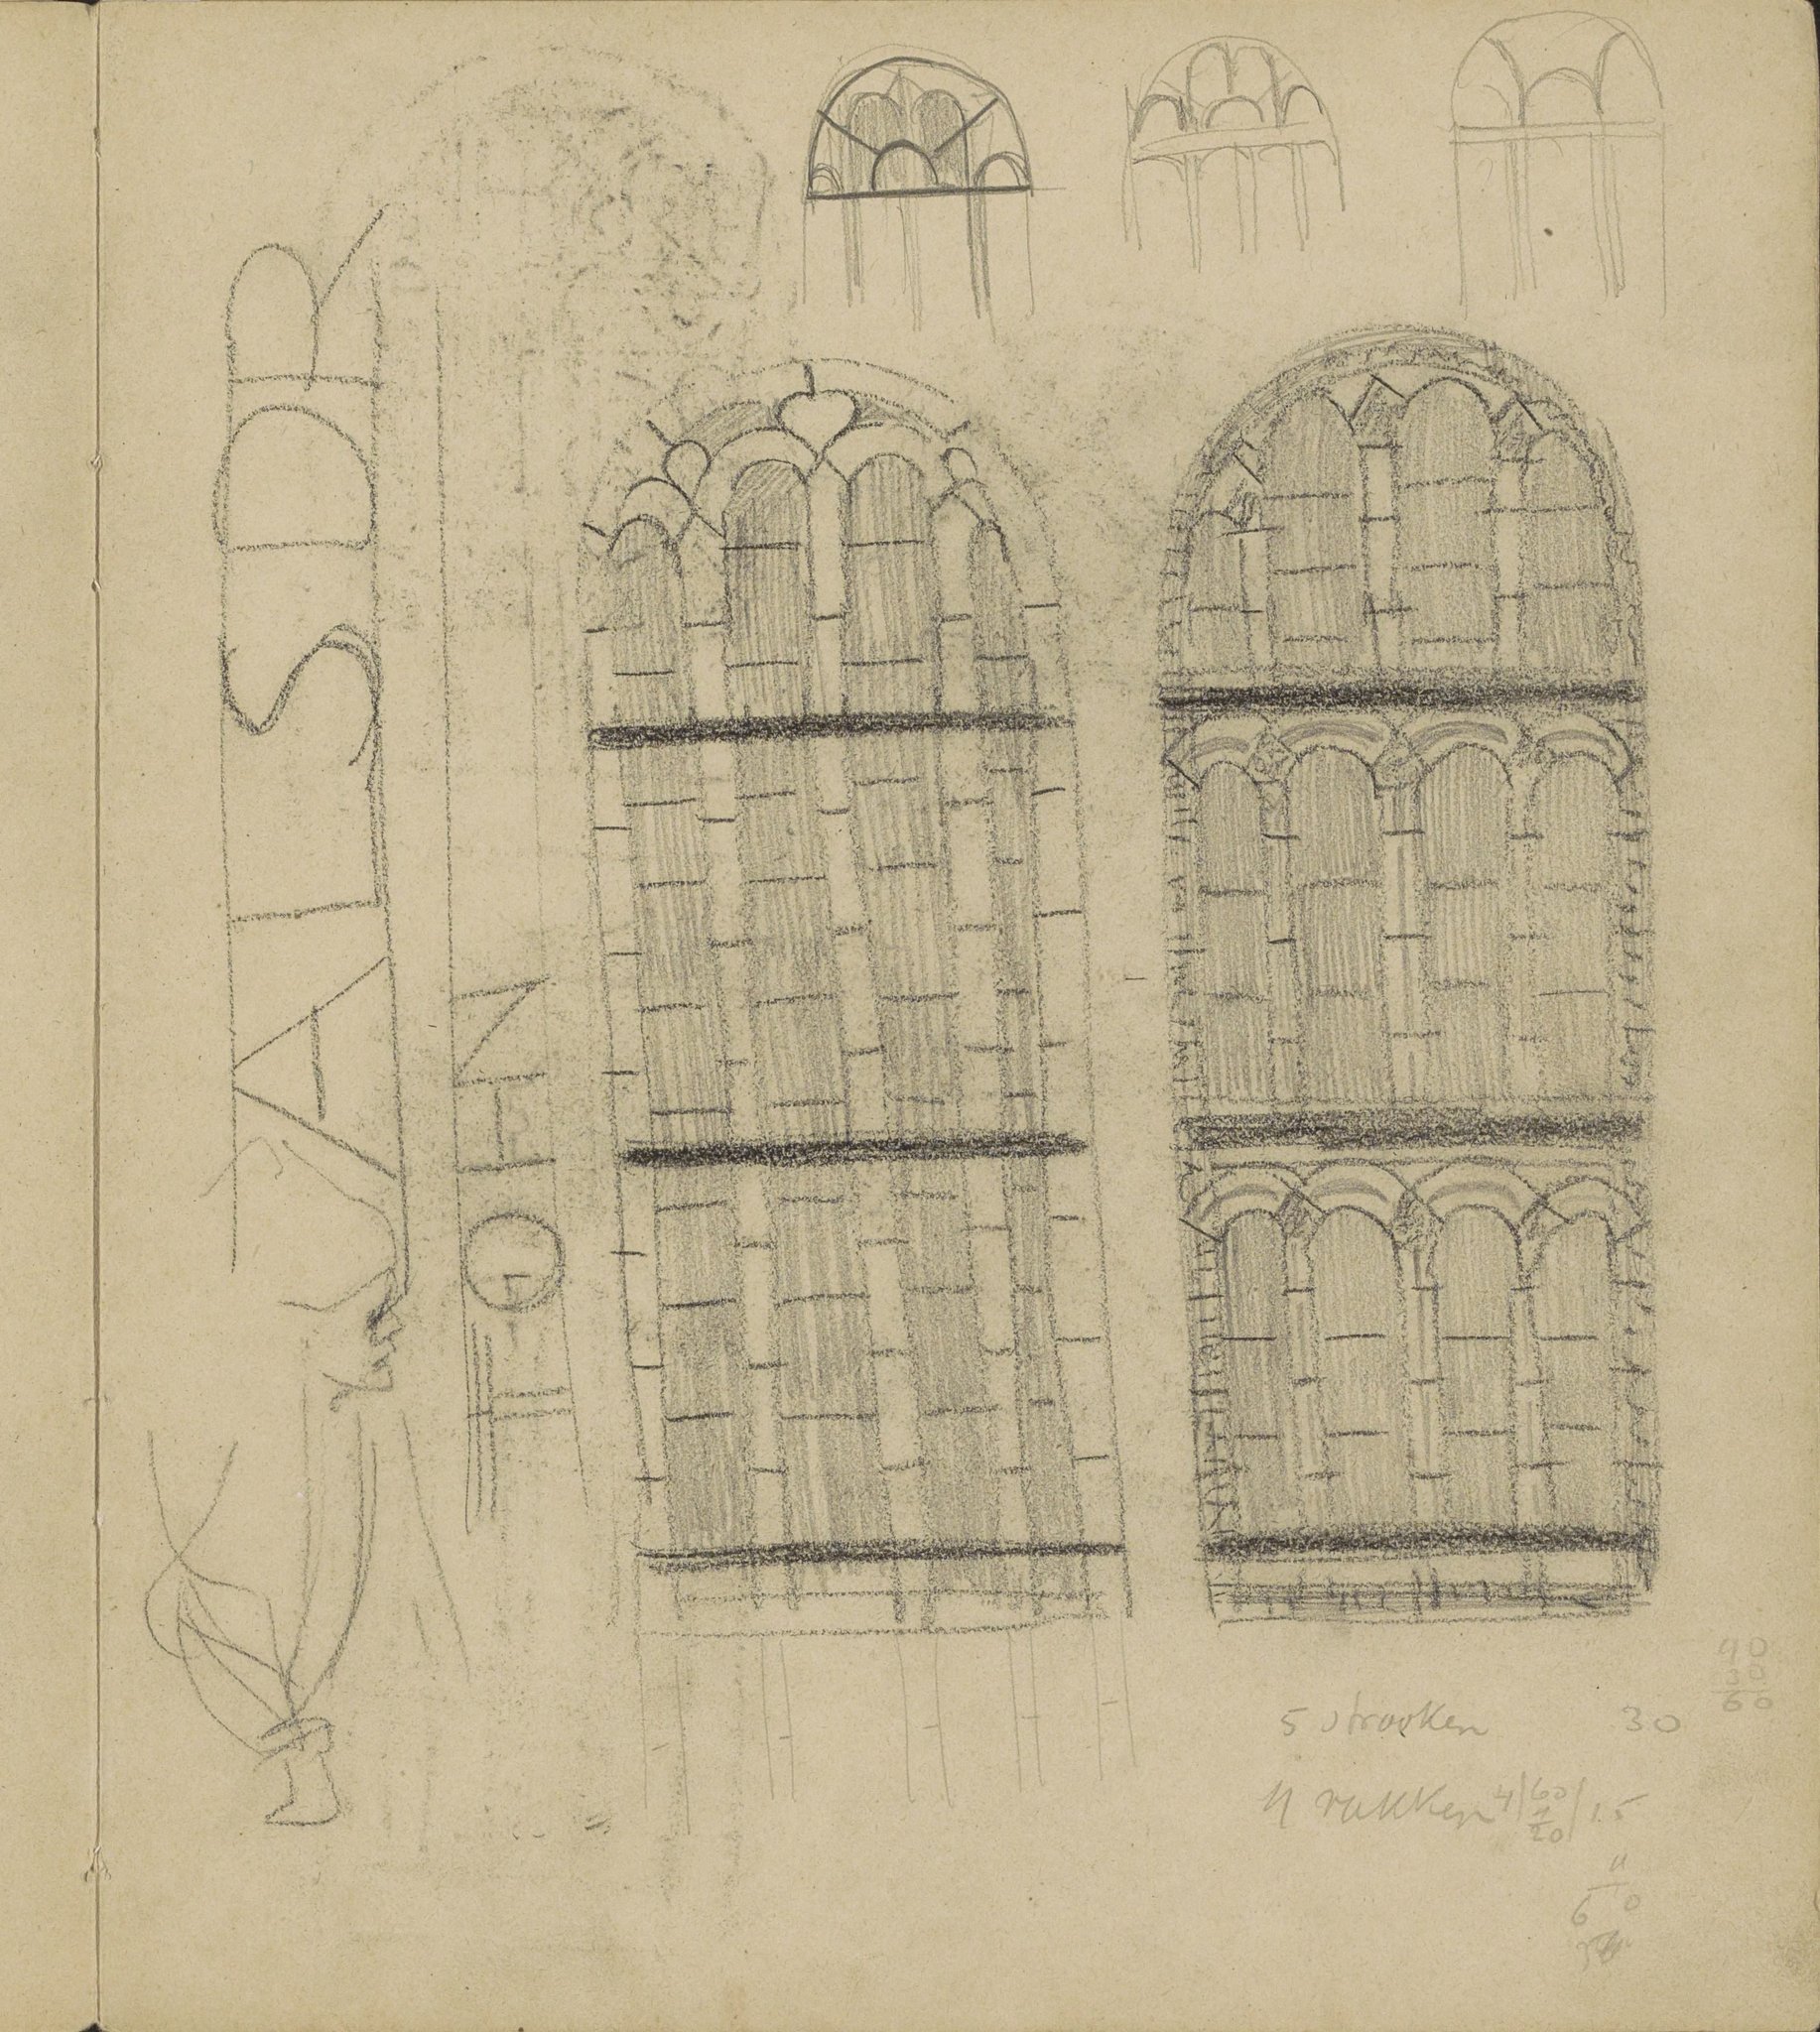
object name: sketchbook leaf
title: Kerkramen en letters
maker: carel adolph lion cachet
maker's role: draughtsman, print maker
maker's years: 1864-1945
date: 1905-1906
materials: chalk, paper, pencil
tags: church-window, e.g. rose-window, fancy letters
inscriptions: annotation: ‘ALSDR/ TOHN/ 5 strooken/ 4 vakken’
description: Blad 8 recto uit een schetsboek met 30 bladen.